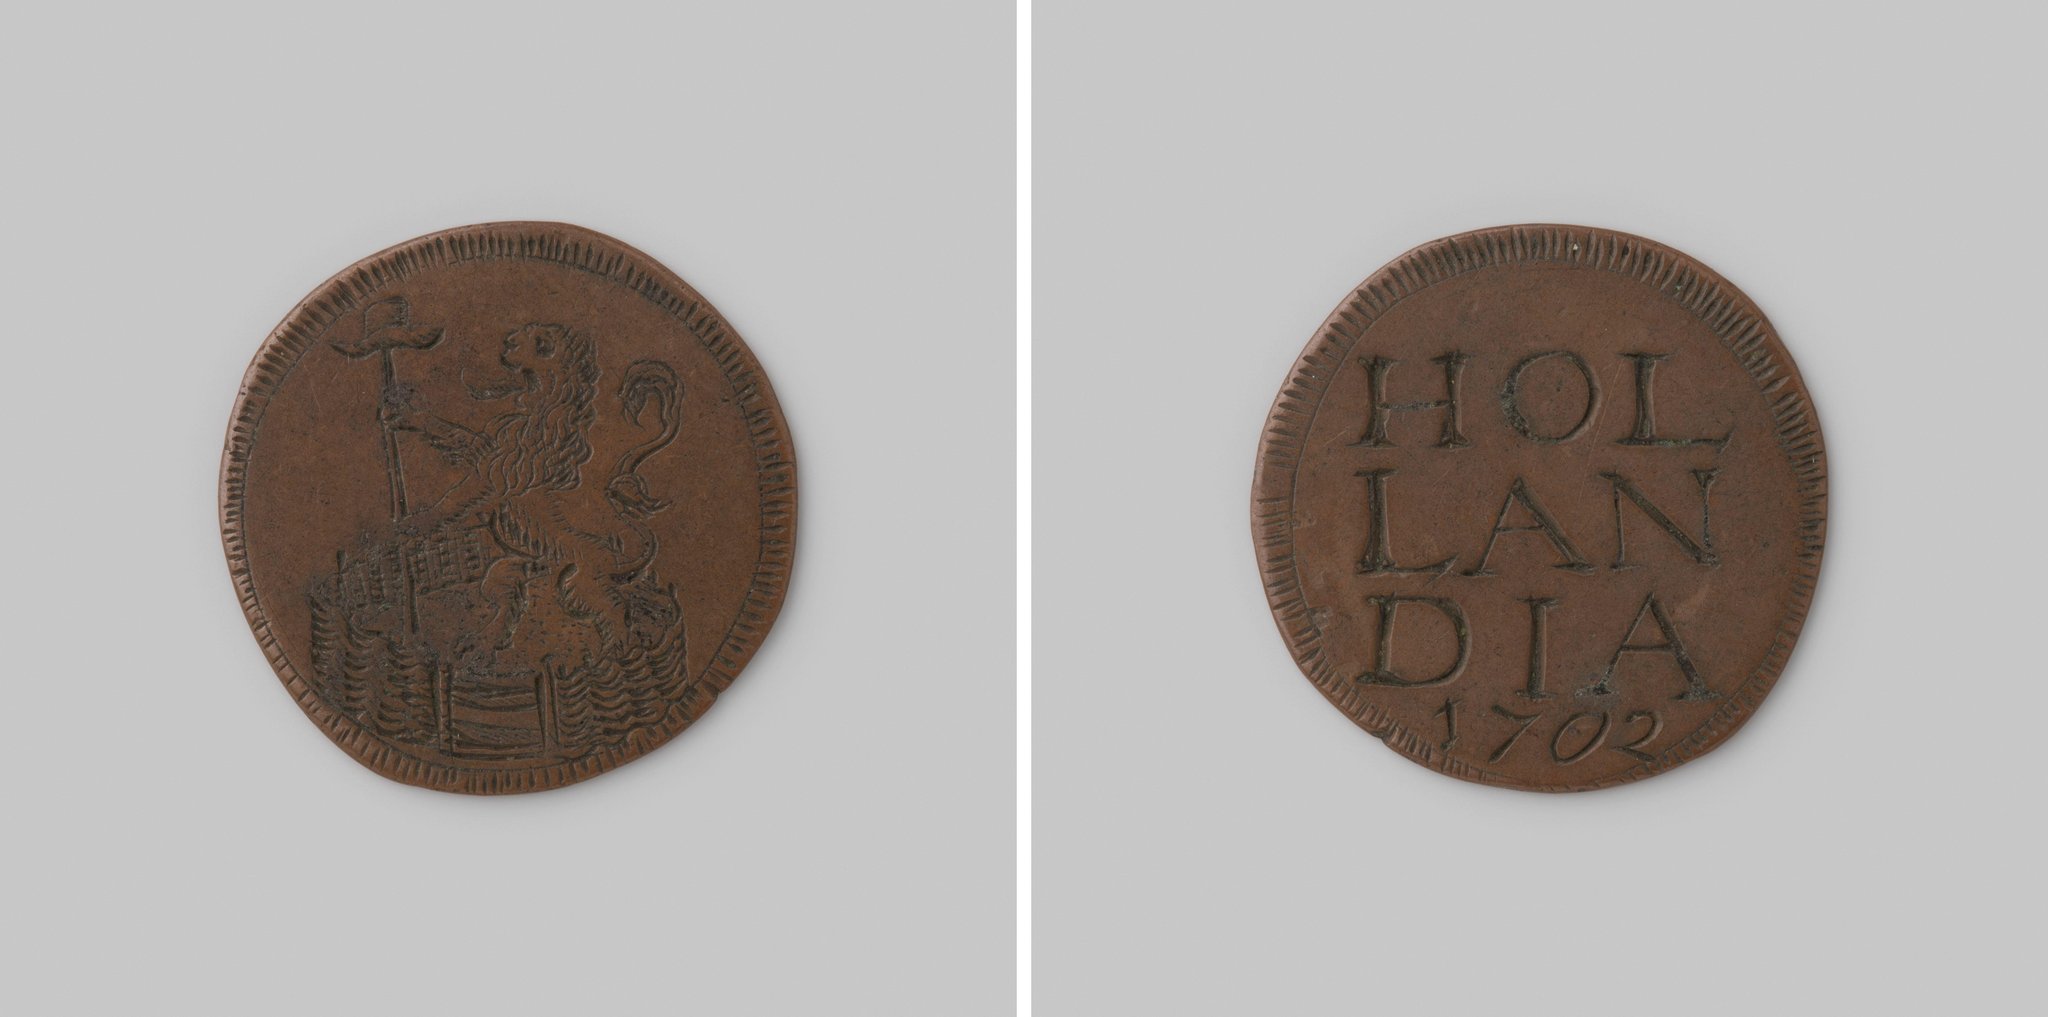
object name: coin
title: Holland, duit, 1702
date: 1702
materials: copper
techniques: engraving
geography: dordrecht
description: Koperen munt. Voorzijde: binnen omheining staande leeuw met vrijheidshoed op speer. Keerzijde: opschrift: provincienaam in drie regels, daaronder jaartal. Voorzijde en keerzijde zijn gegraveerd op het overlijden van Willem III